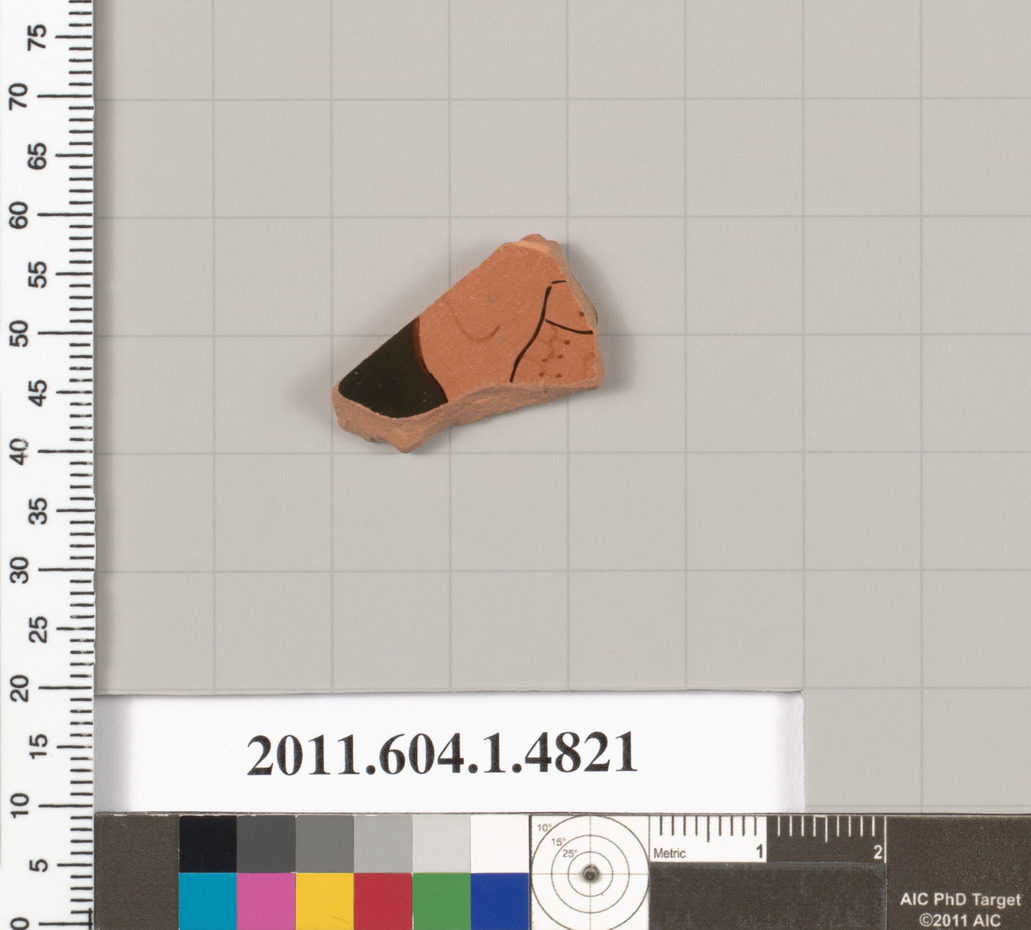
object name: kylix fragment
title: Terracotta fragment of a kylix (drinking cup)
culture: greek, attic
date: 500-480 BCE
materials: terracotta